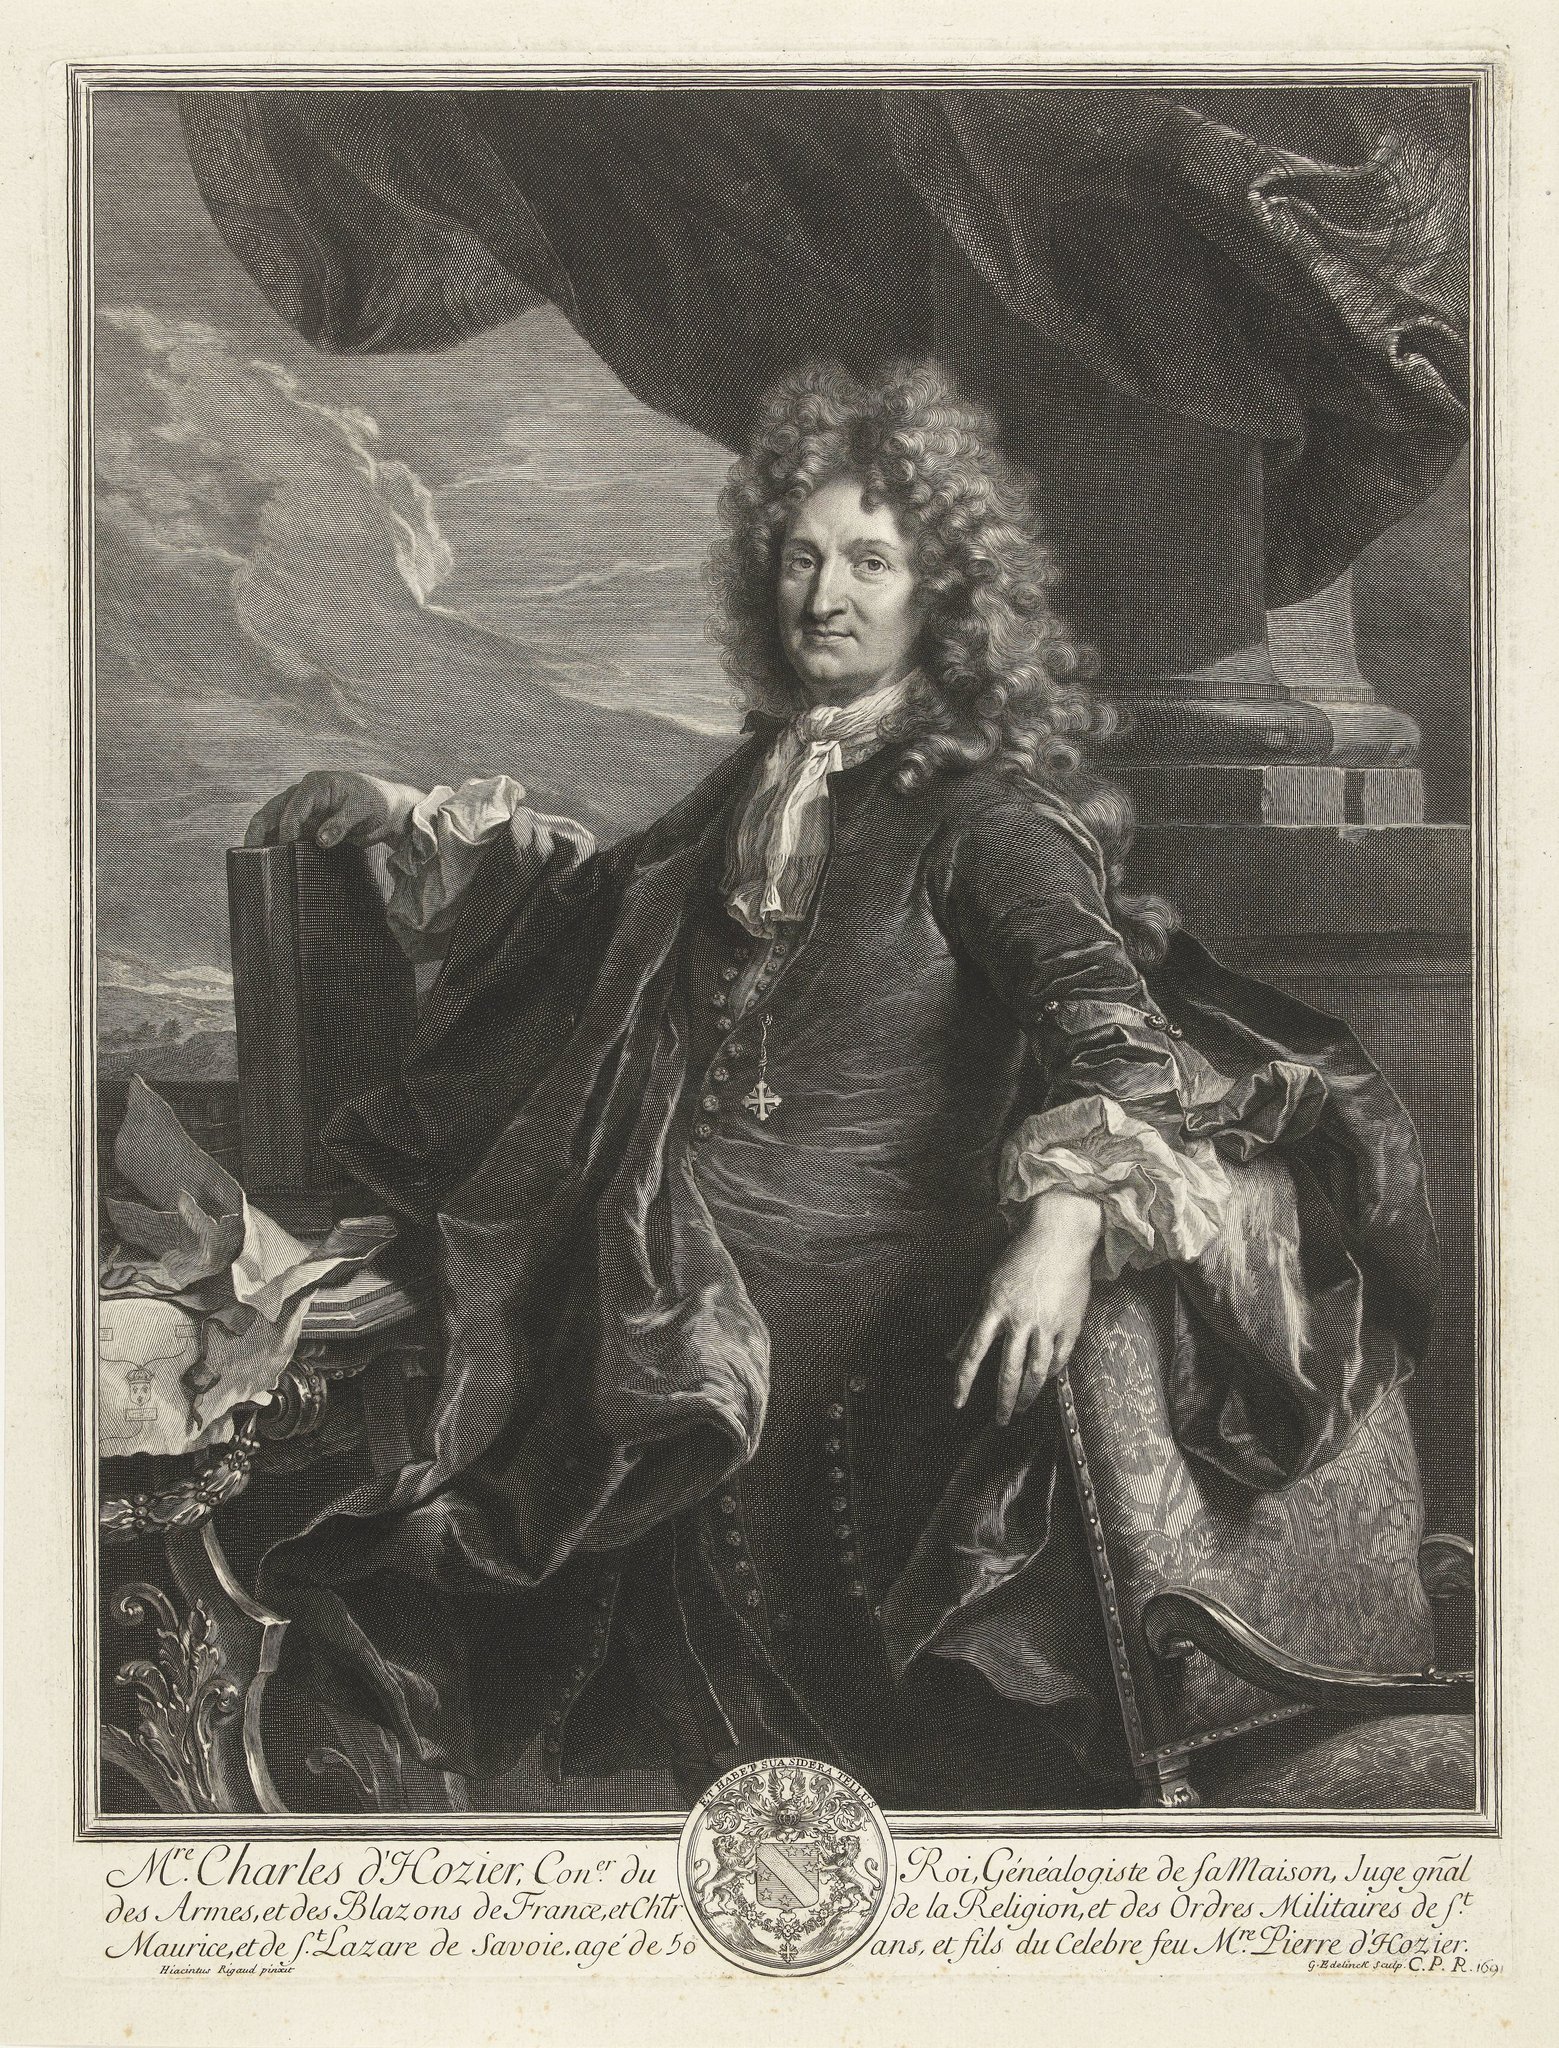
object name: print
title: Portret van Charles d'Hozier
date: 1691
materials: paper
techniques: engraving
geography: france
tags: genealoog, charles-rené d' hozier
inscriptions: collector's mark: Lugt 240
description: Charles d'Hozier (1640-1732), wapenkoning van Lodewijk XIV, afgebeeld met linker arm over de rugleuning van een stoel en rechter hand op een boek. Op de achtergrond een pilaar met draperie en een wolkenlucht. Onder het portret drie regels tekst in Latijn, waartussen een wapen.